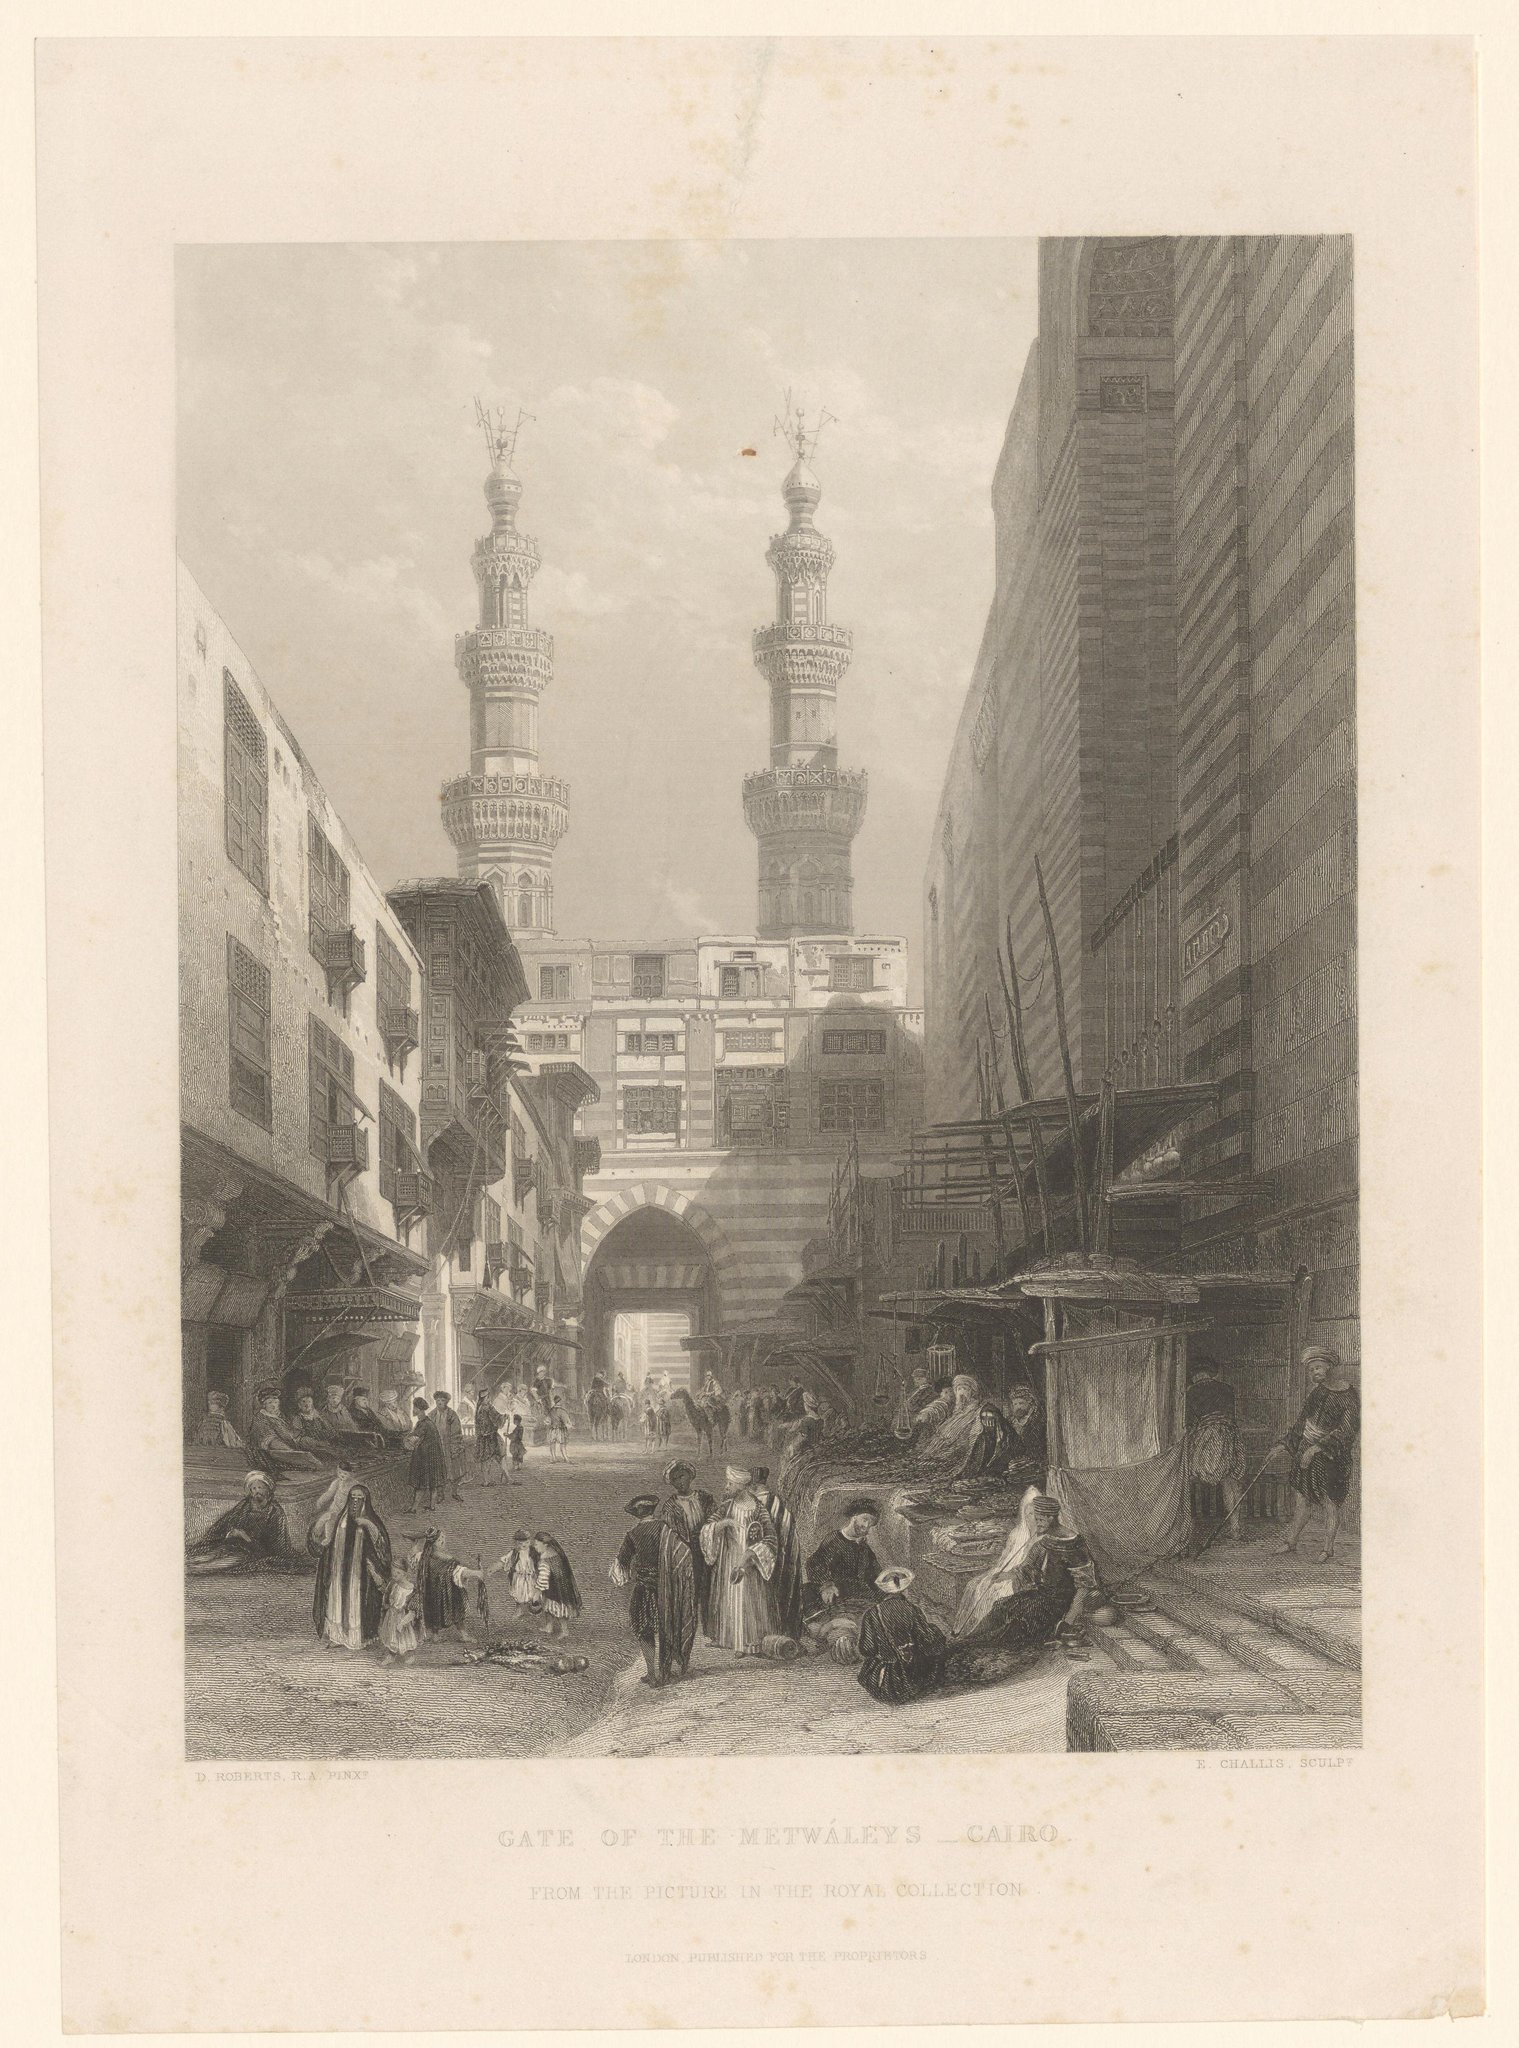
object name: print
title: Gate of the Metwáleys - Cairo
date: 1846-1855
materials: paper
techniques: engraving, etching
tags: market, city-gate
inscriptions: collector's mark: Lugt 2228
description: Prent gebaseerd op het schilderij door David Roberts gemaakt tussen 1839 en 1840 in de collectie van de Royal Collection Trust onder inventaris nummer: 403602. Deze prent is gebruikt in: C. H. Hall's Royal Gallery of Art. Londen: P & D. Colnaghi & Co, Manchester: T Agnew & Sons, 1855. De uitgave is gebonden in Londen door Riviere (zie inventaris nummer: 1112443, tevens in de Royal Collection Trust).